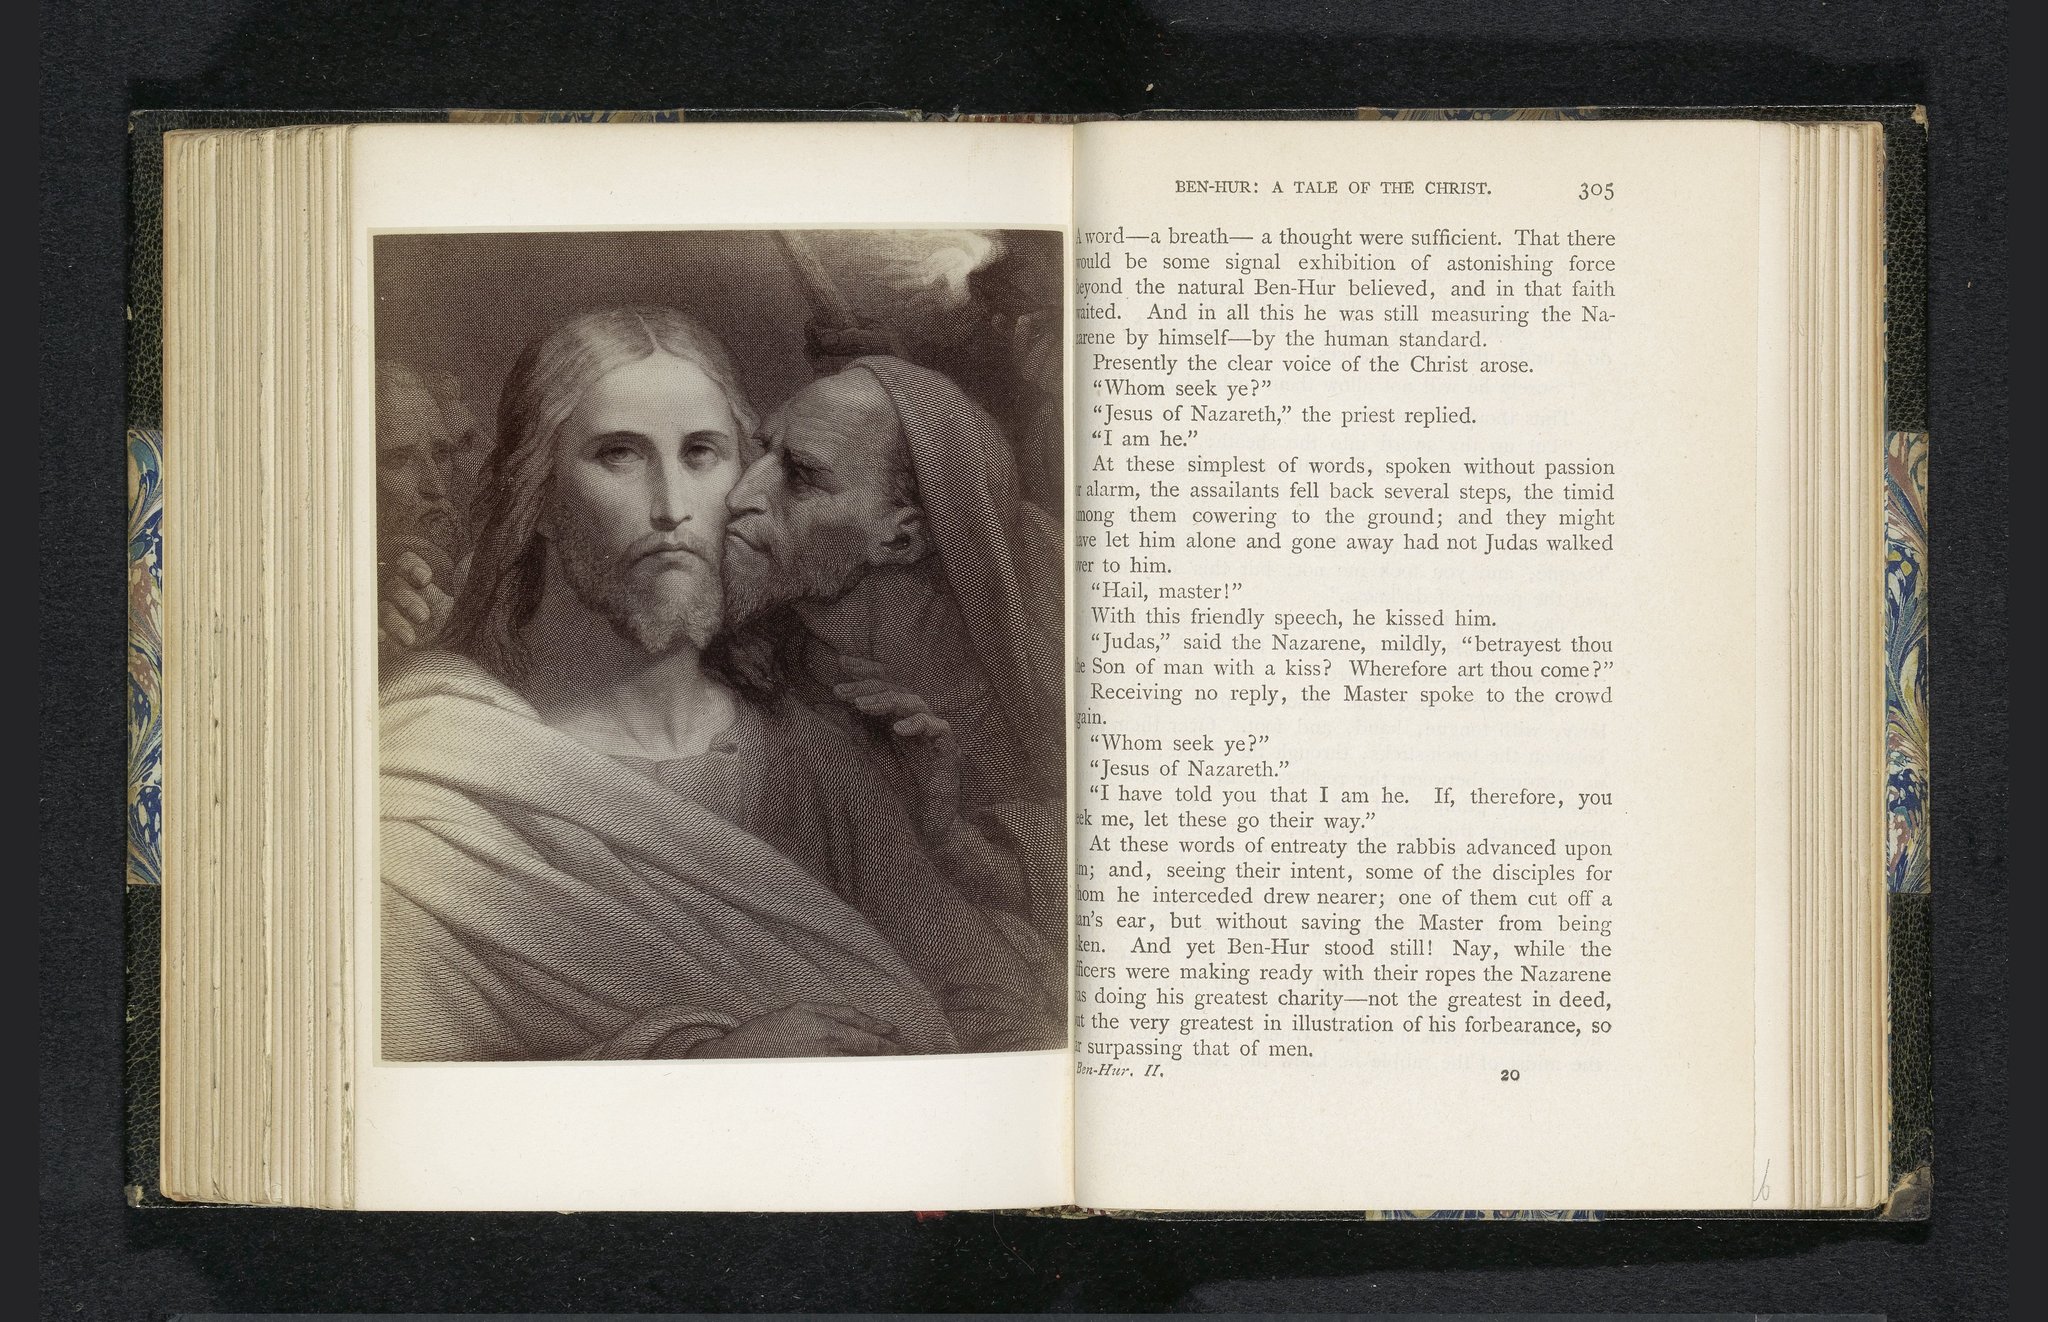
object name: photograph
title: Fotoreproductie van een prent naar een schilderij, voorstellende Judas kust Christus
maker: Anonymous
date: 1883-1888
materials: photographic support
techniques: albumen print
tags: the kiss of judas: accompanied by soldiers with torches and lanterns, he kisses christ